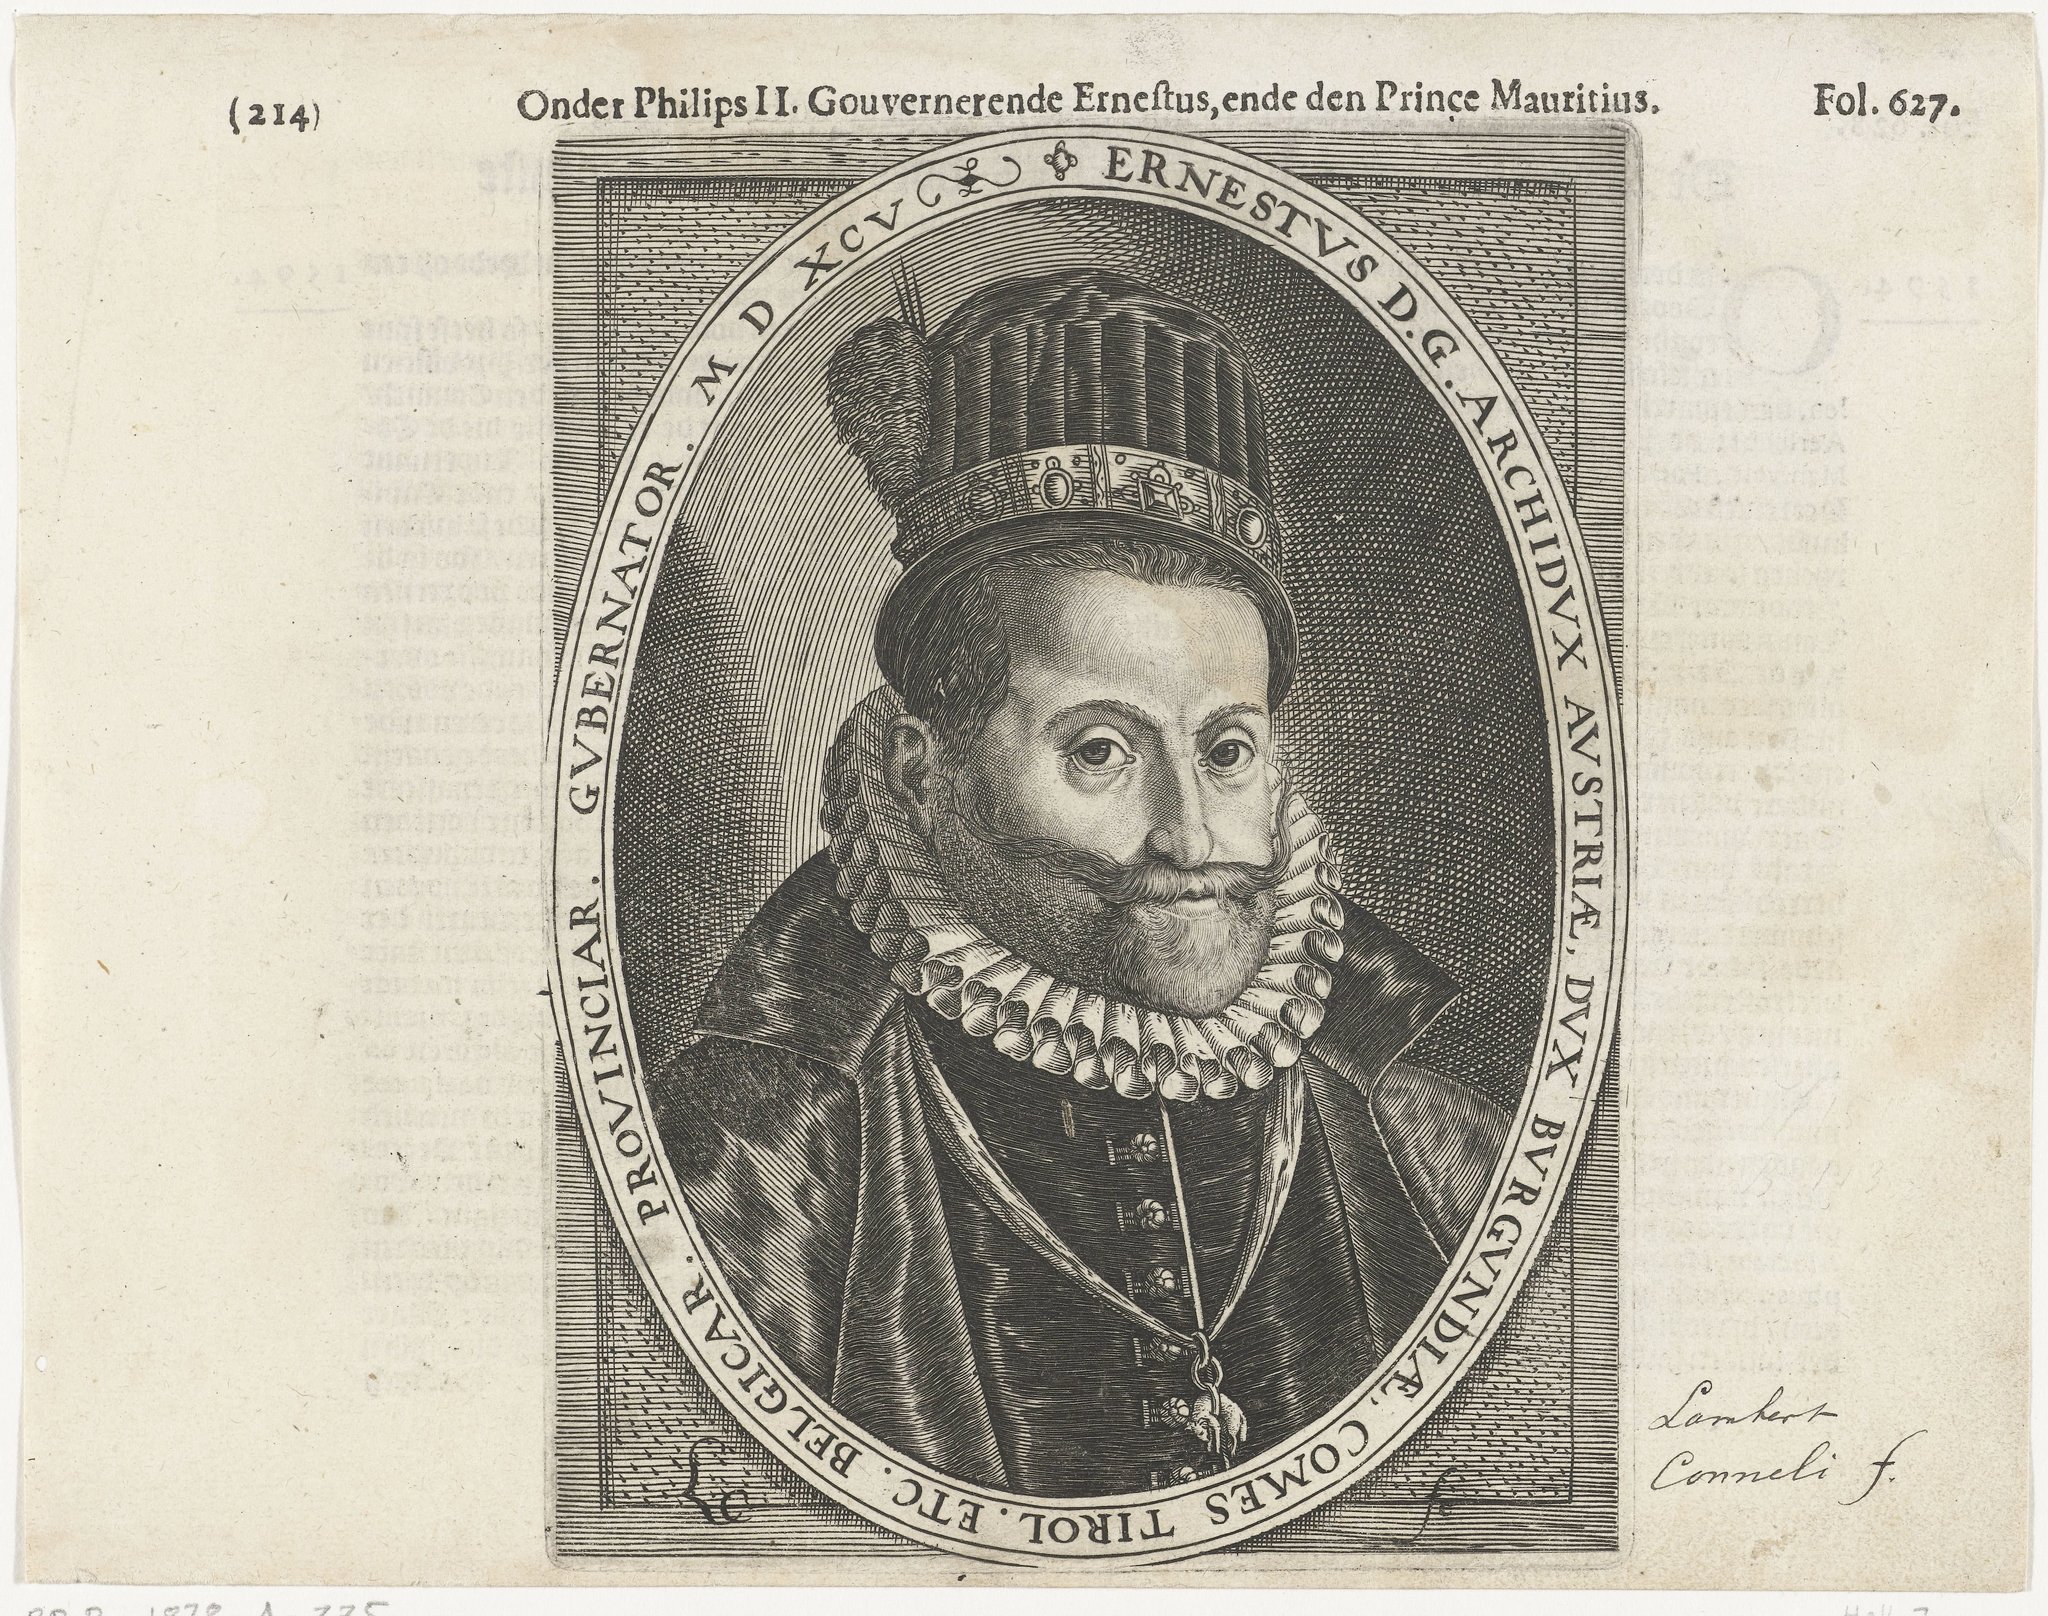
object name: book illustration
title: Portret van Ernst van Oostenrijk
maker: lambert cornelisz.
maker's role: draughtsman, print maker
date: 1593-1612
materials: paper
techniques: engraving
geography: amsterdam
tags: ruler, sovereign, knighthood order of the golden fleece - insignia of a knighthood order, e.g.: badge, chain (with name of order)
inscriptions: collector's mark: Lugt 2228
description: Portret van Ernst aartshertog van Oostenrijk en landvoogd van de Zuidelijke Nederlanden, in ovaal met randschrift. Bladzijde uit een boek met tekst op het verso.